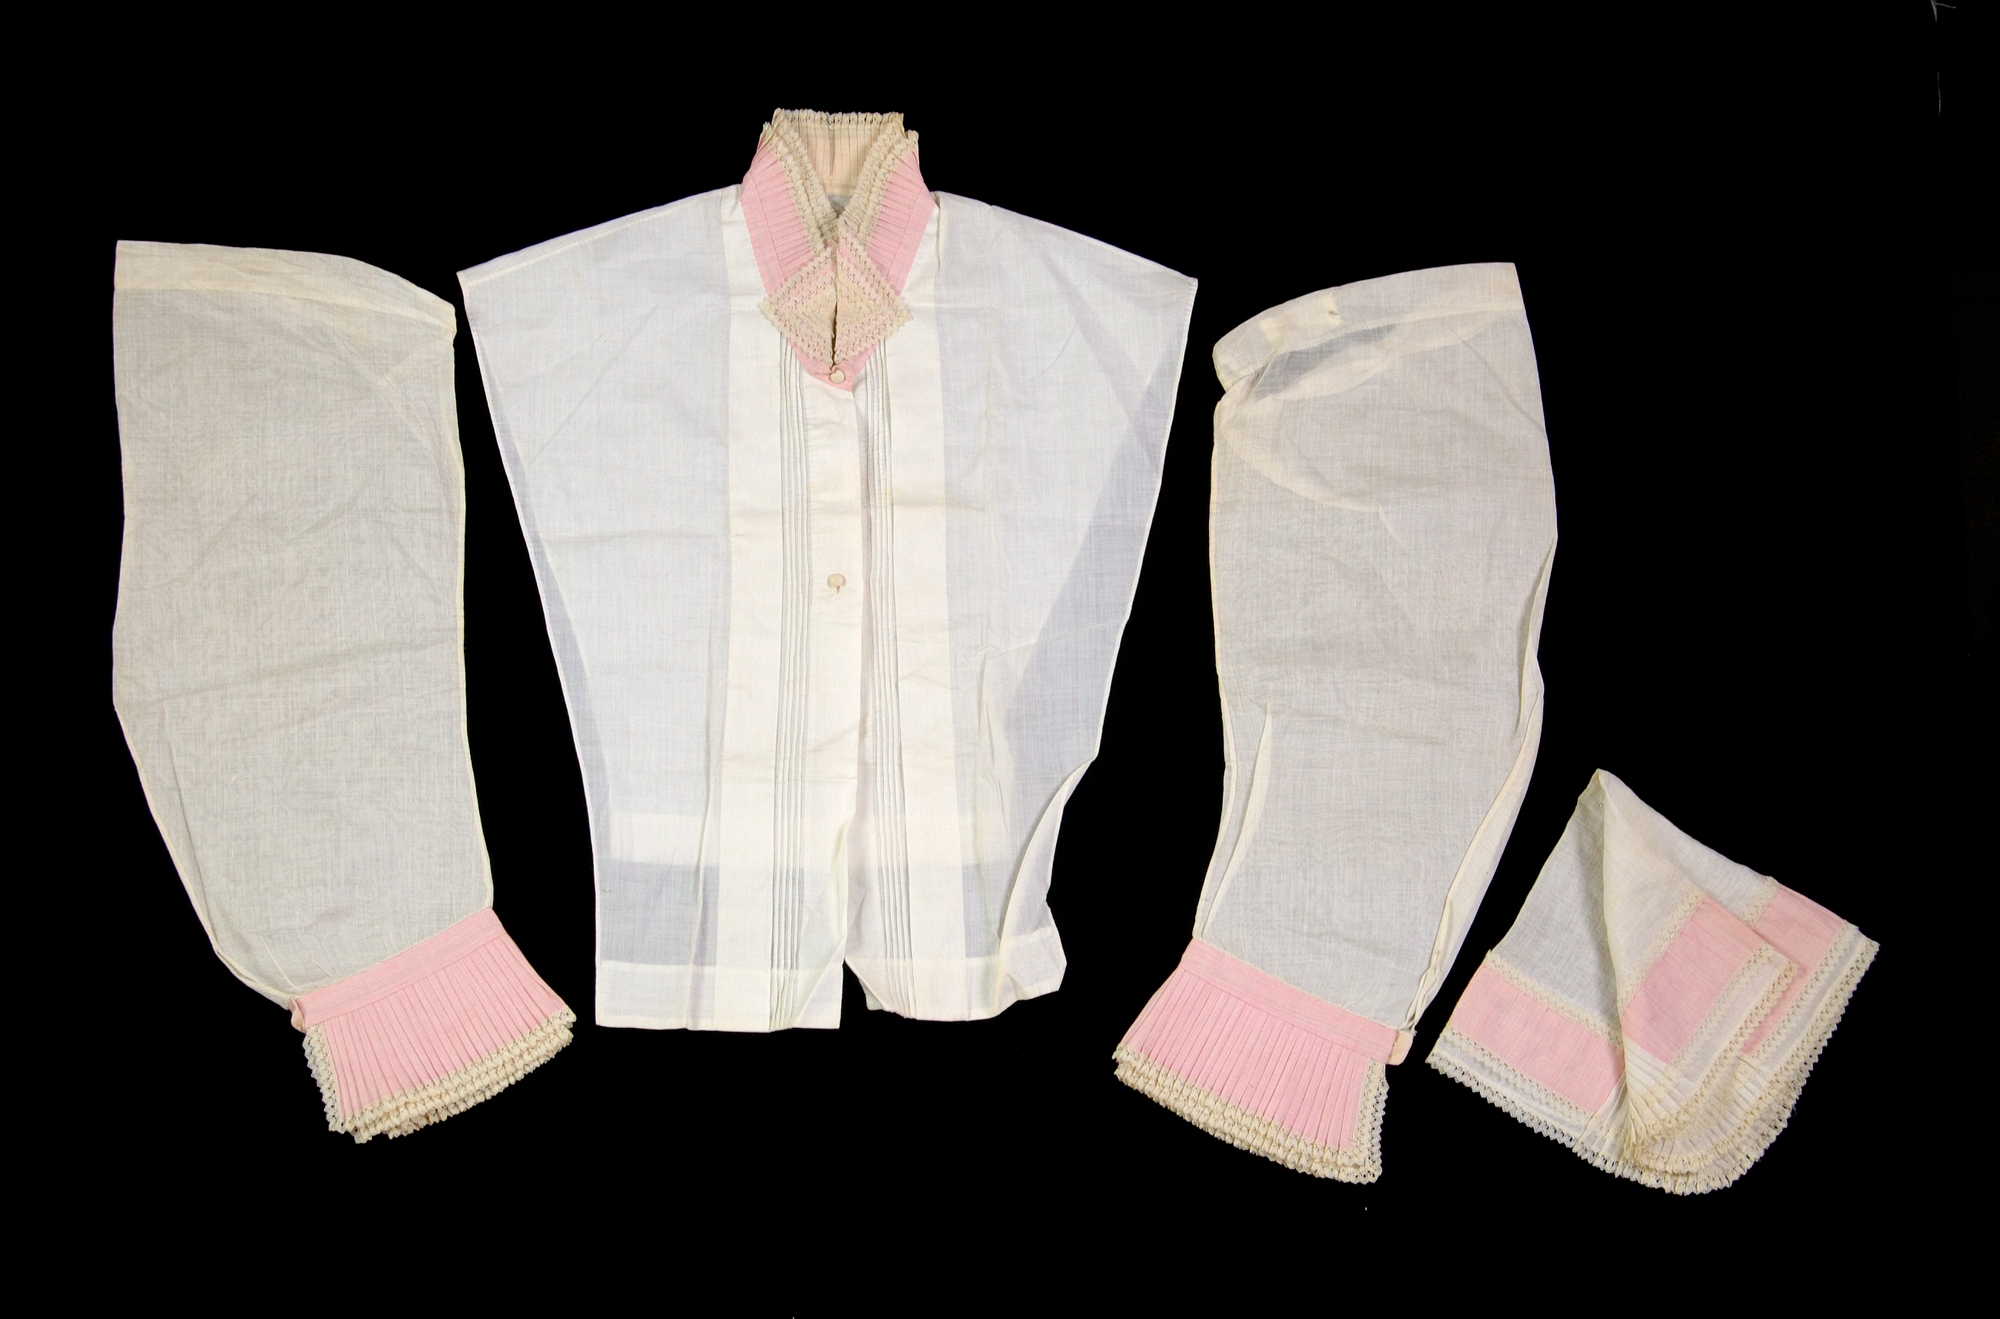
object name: accessory set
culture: french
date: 1865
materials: cotton, linen